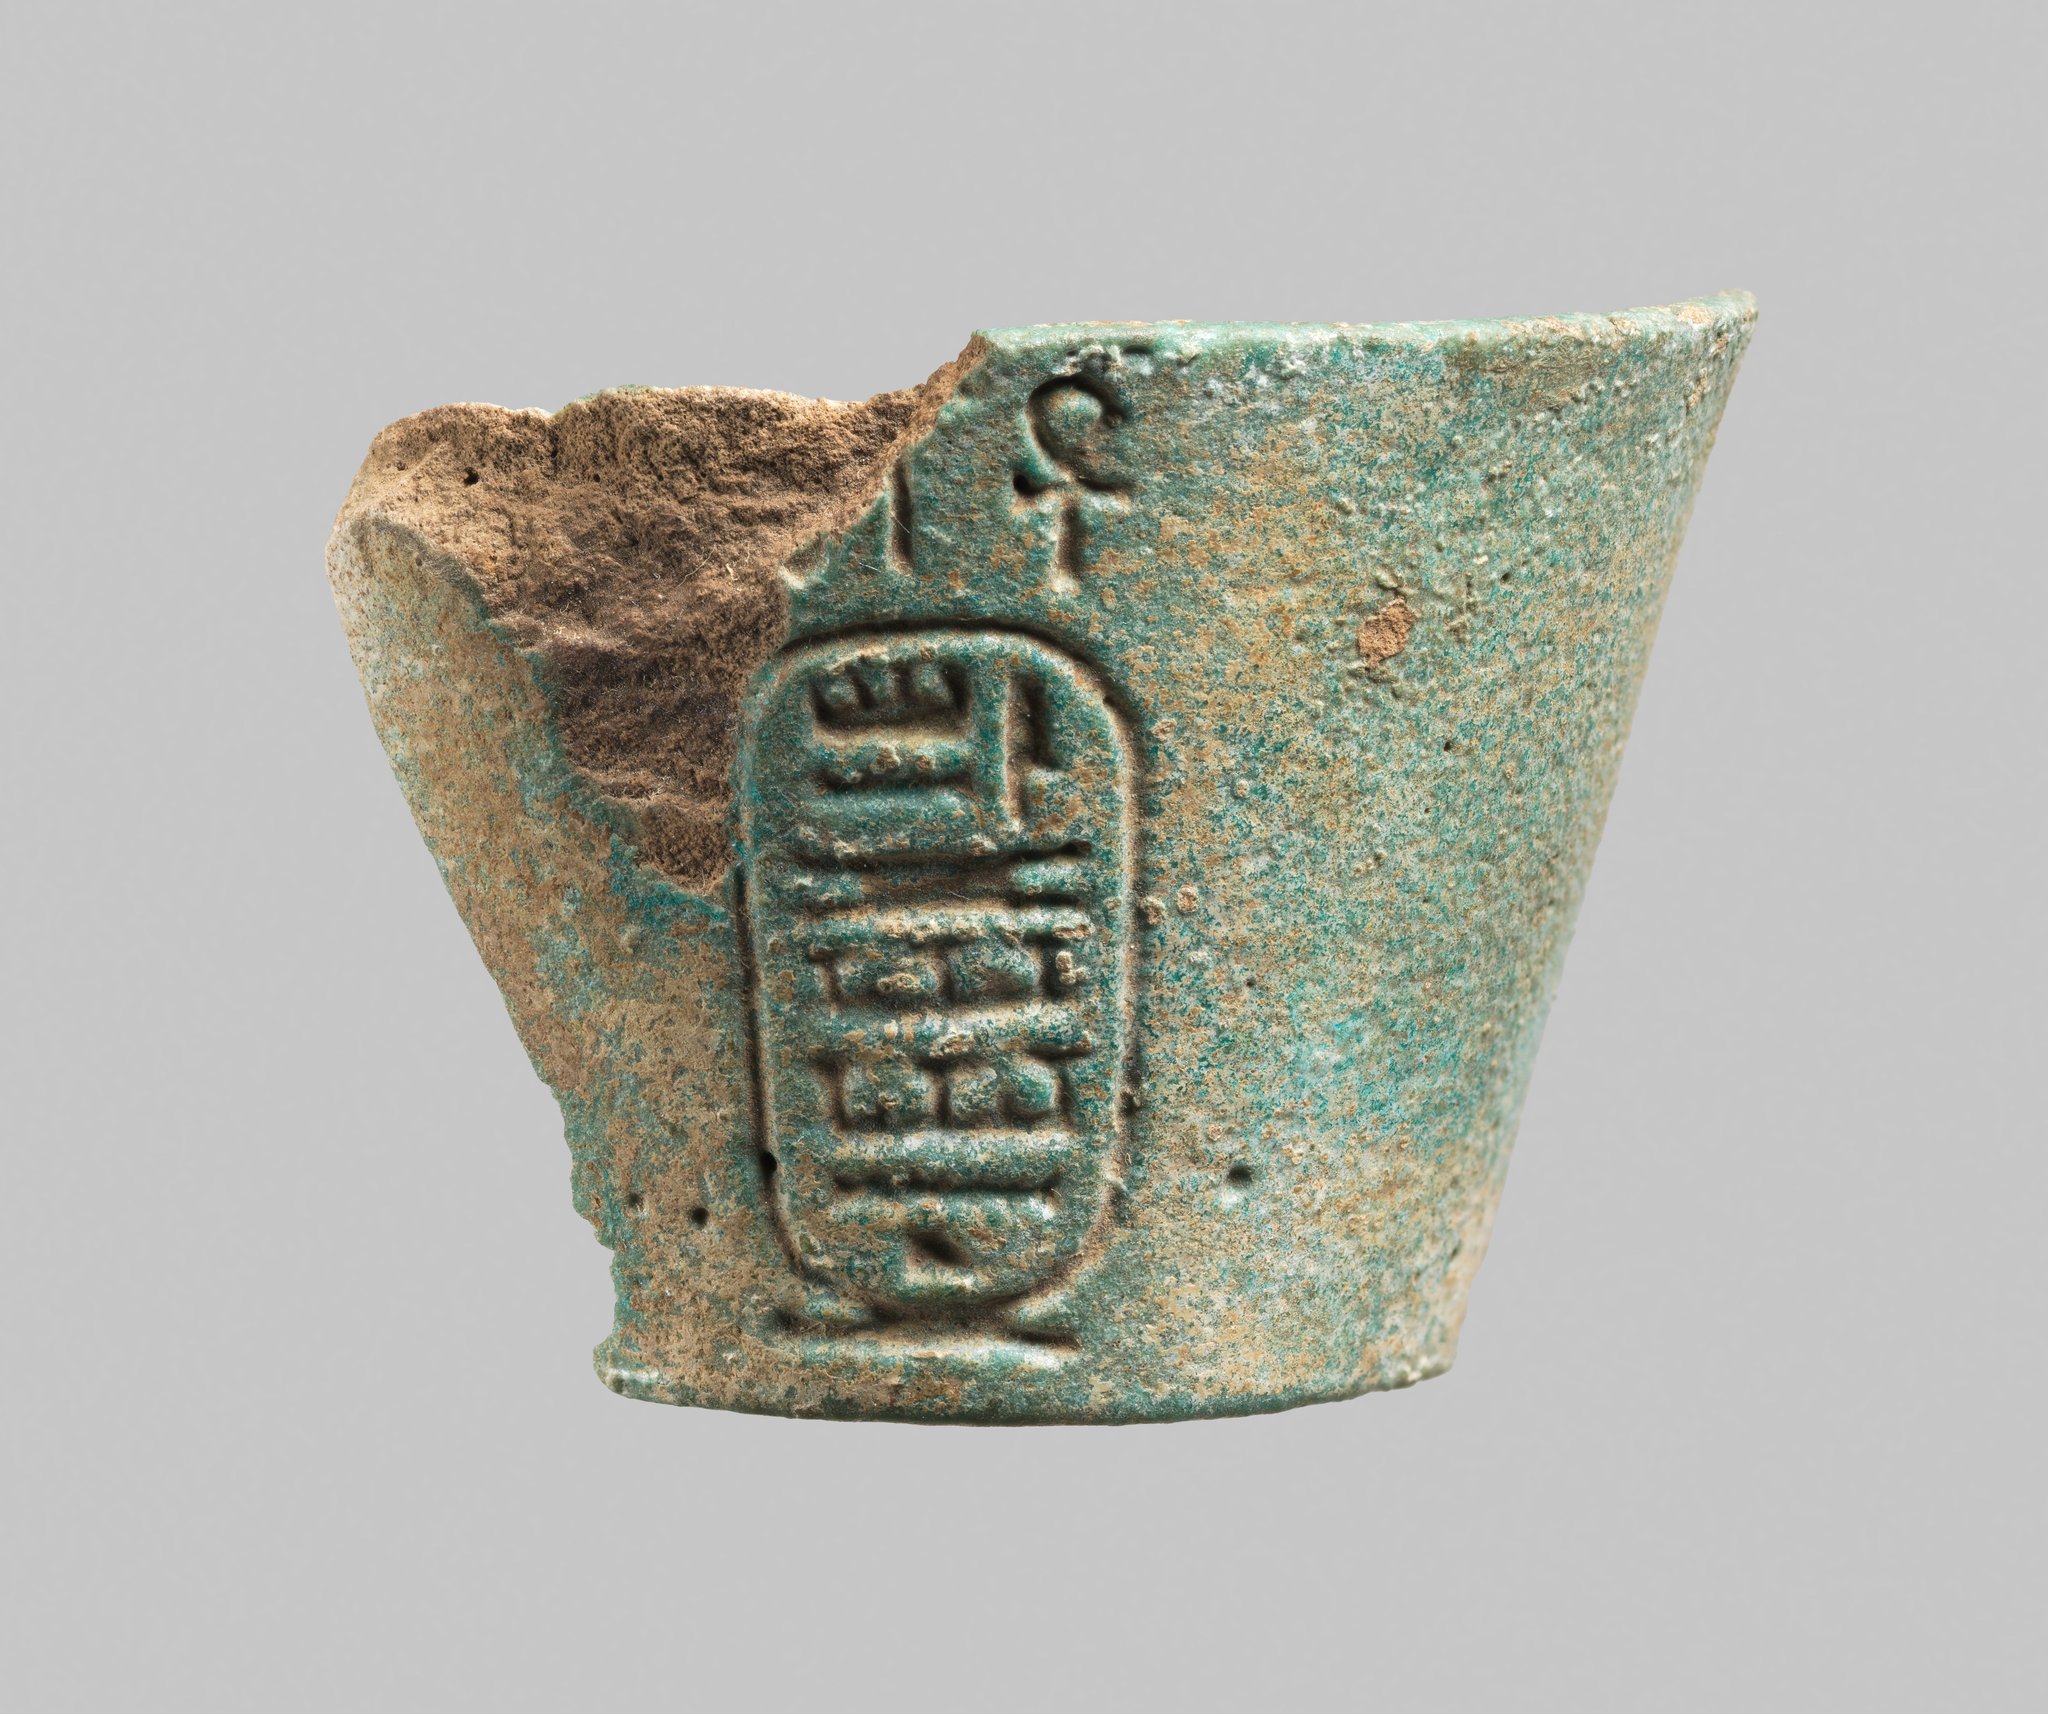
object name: cup fragment, meriamon sheshonq vi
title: Cup fragment of Meriamon-Sheshonq, designated Sheshonq VI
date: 793-787 BCE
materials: faience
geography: eastern delta